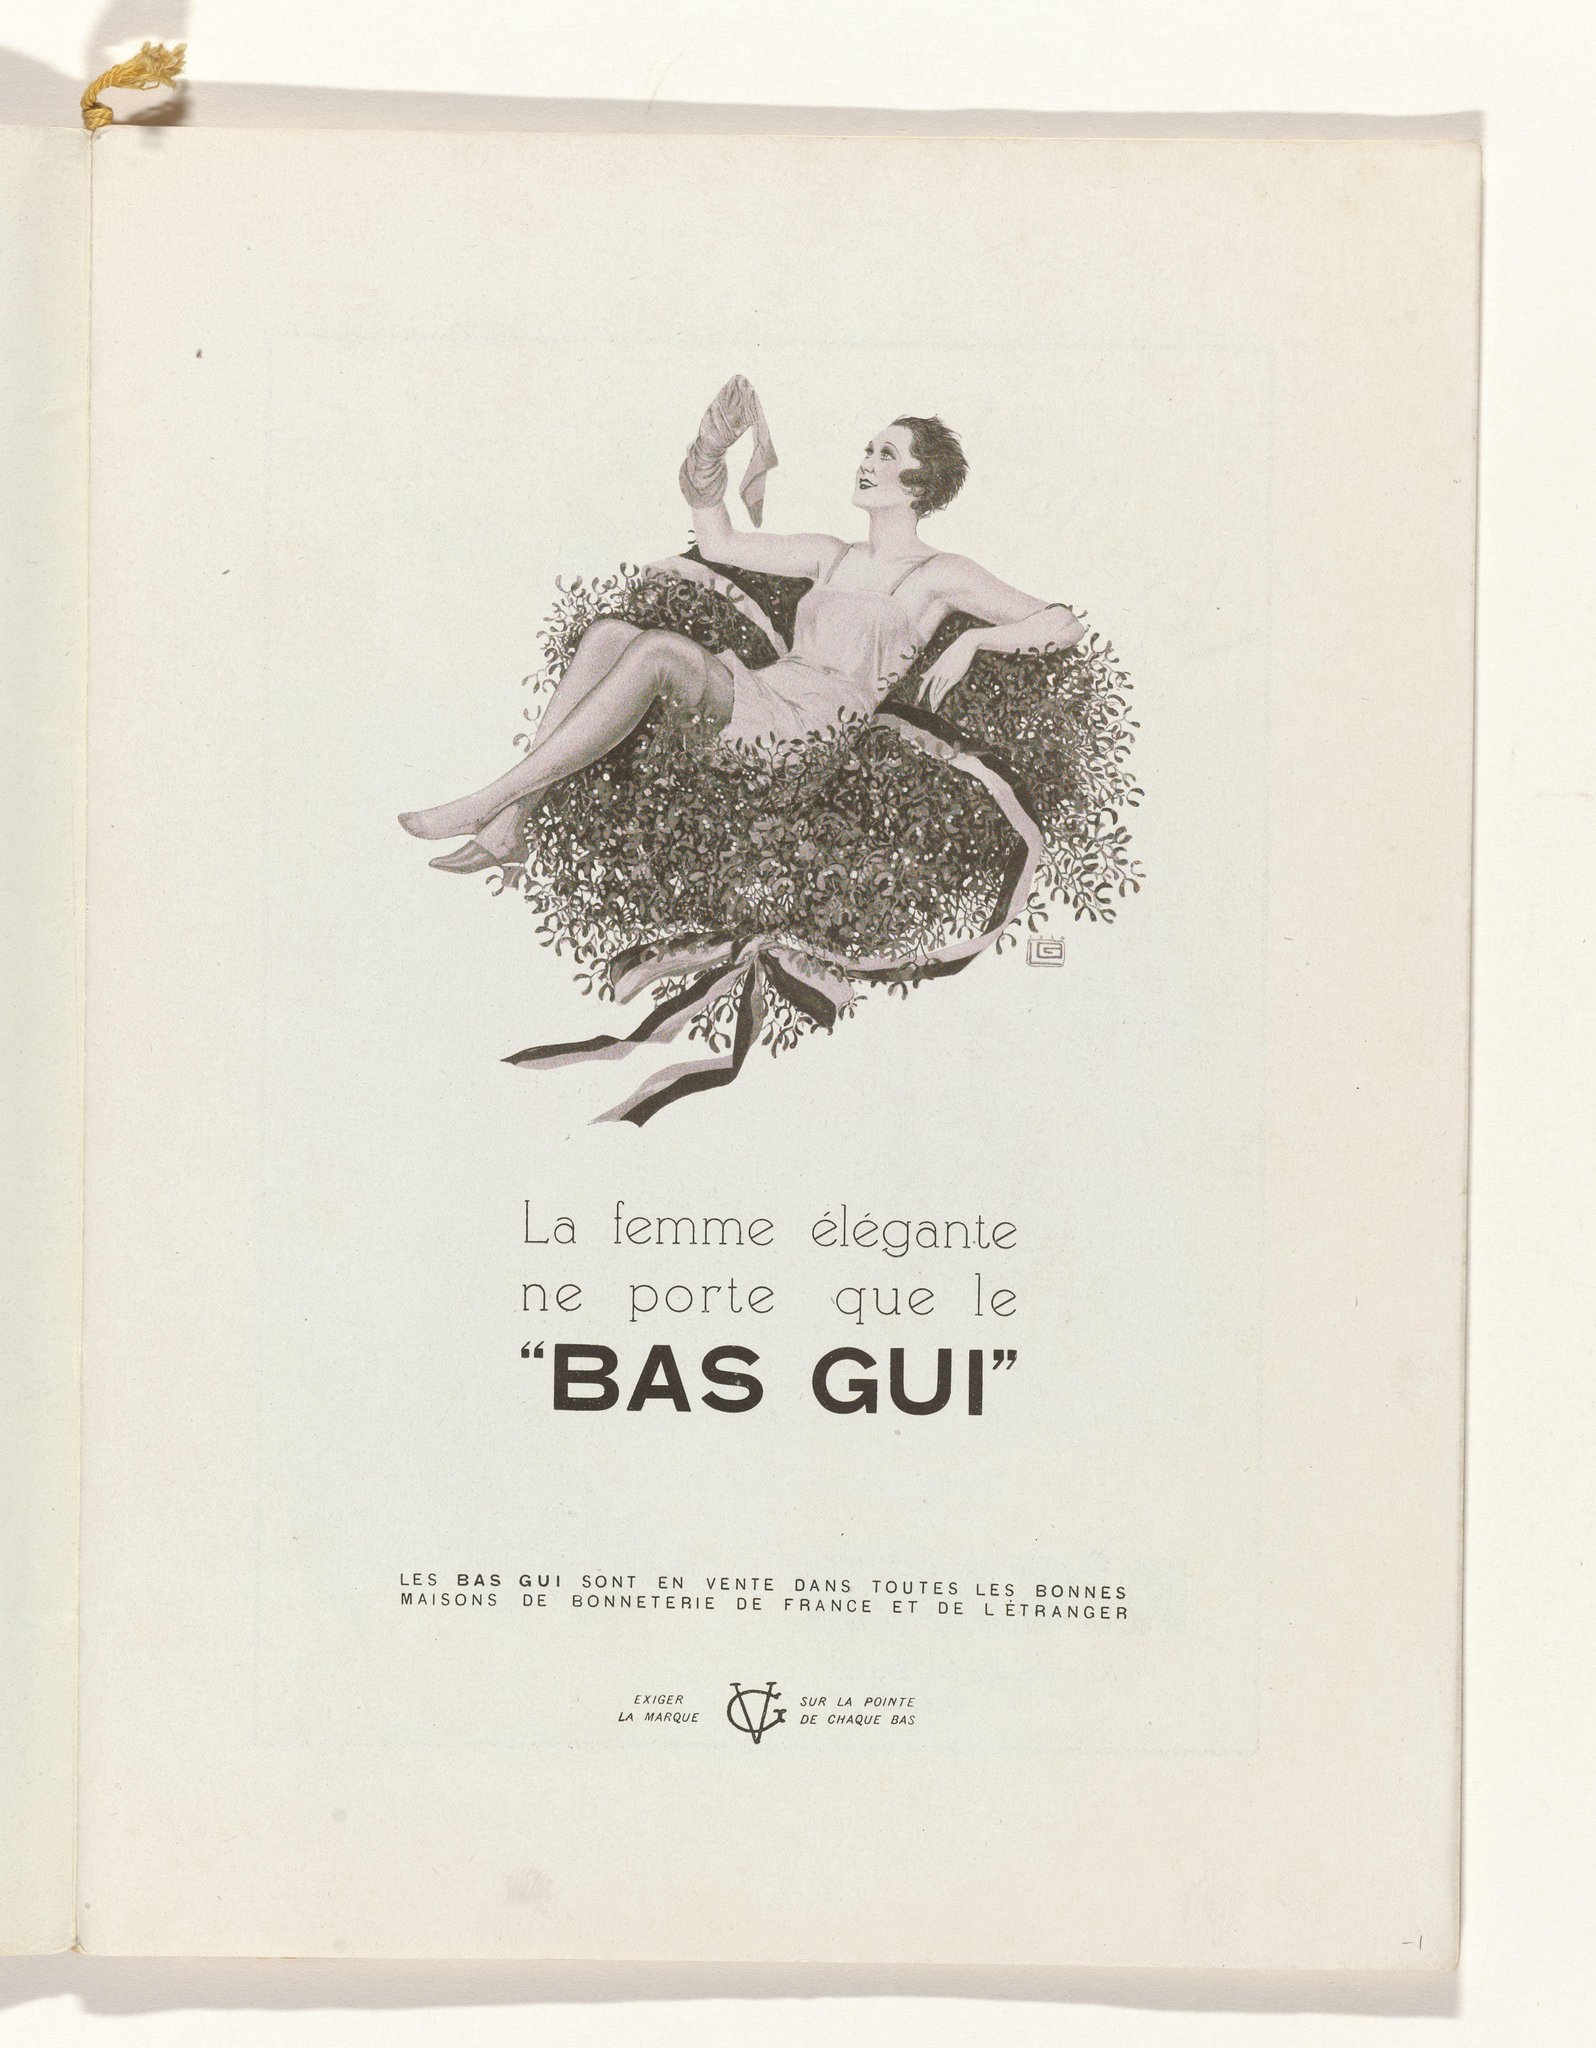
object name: fashion print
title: Art - Goût - Beauté, Feuillets de l' élégance féminine, Novembre 1931, No. 135, 12e Année, p. 1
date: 1931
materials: paper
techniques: photography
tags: border, ribbon, braid (+ women's clothes), plants and herbs: mistletoe, fashion plates, dress, gown (+ women's clothes), stockings, socks (+ women's clothes)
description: Advertentie voor kousen 'bas gui'. Pagina uit het modetijdschrift Art-Goût-Beauté (1920-1933).